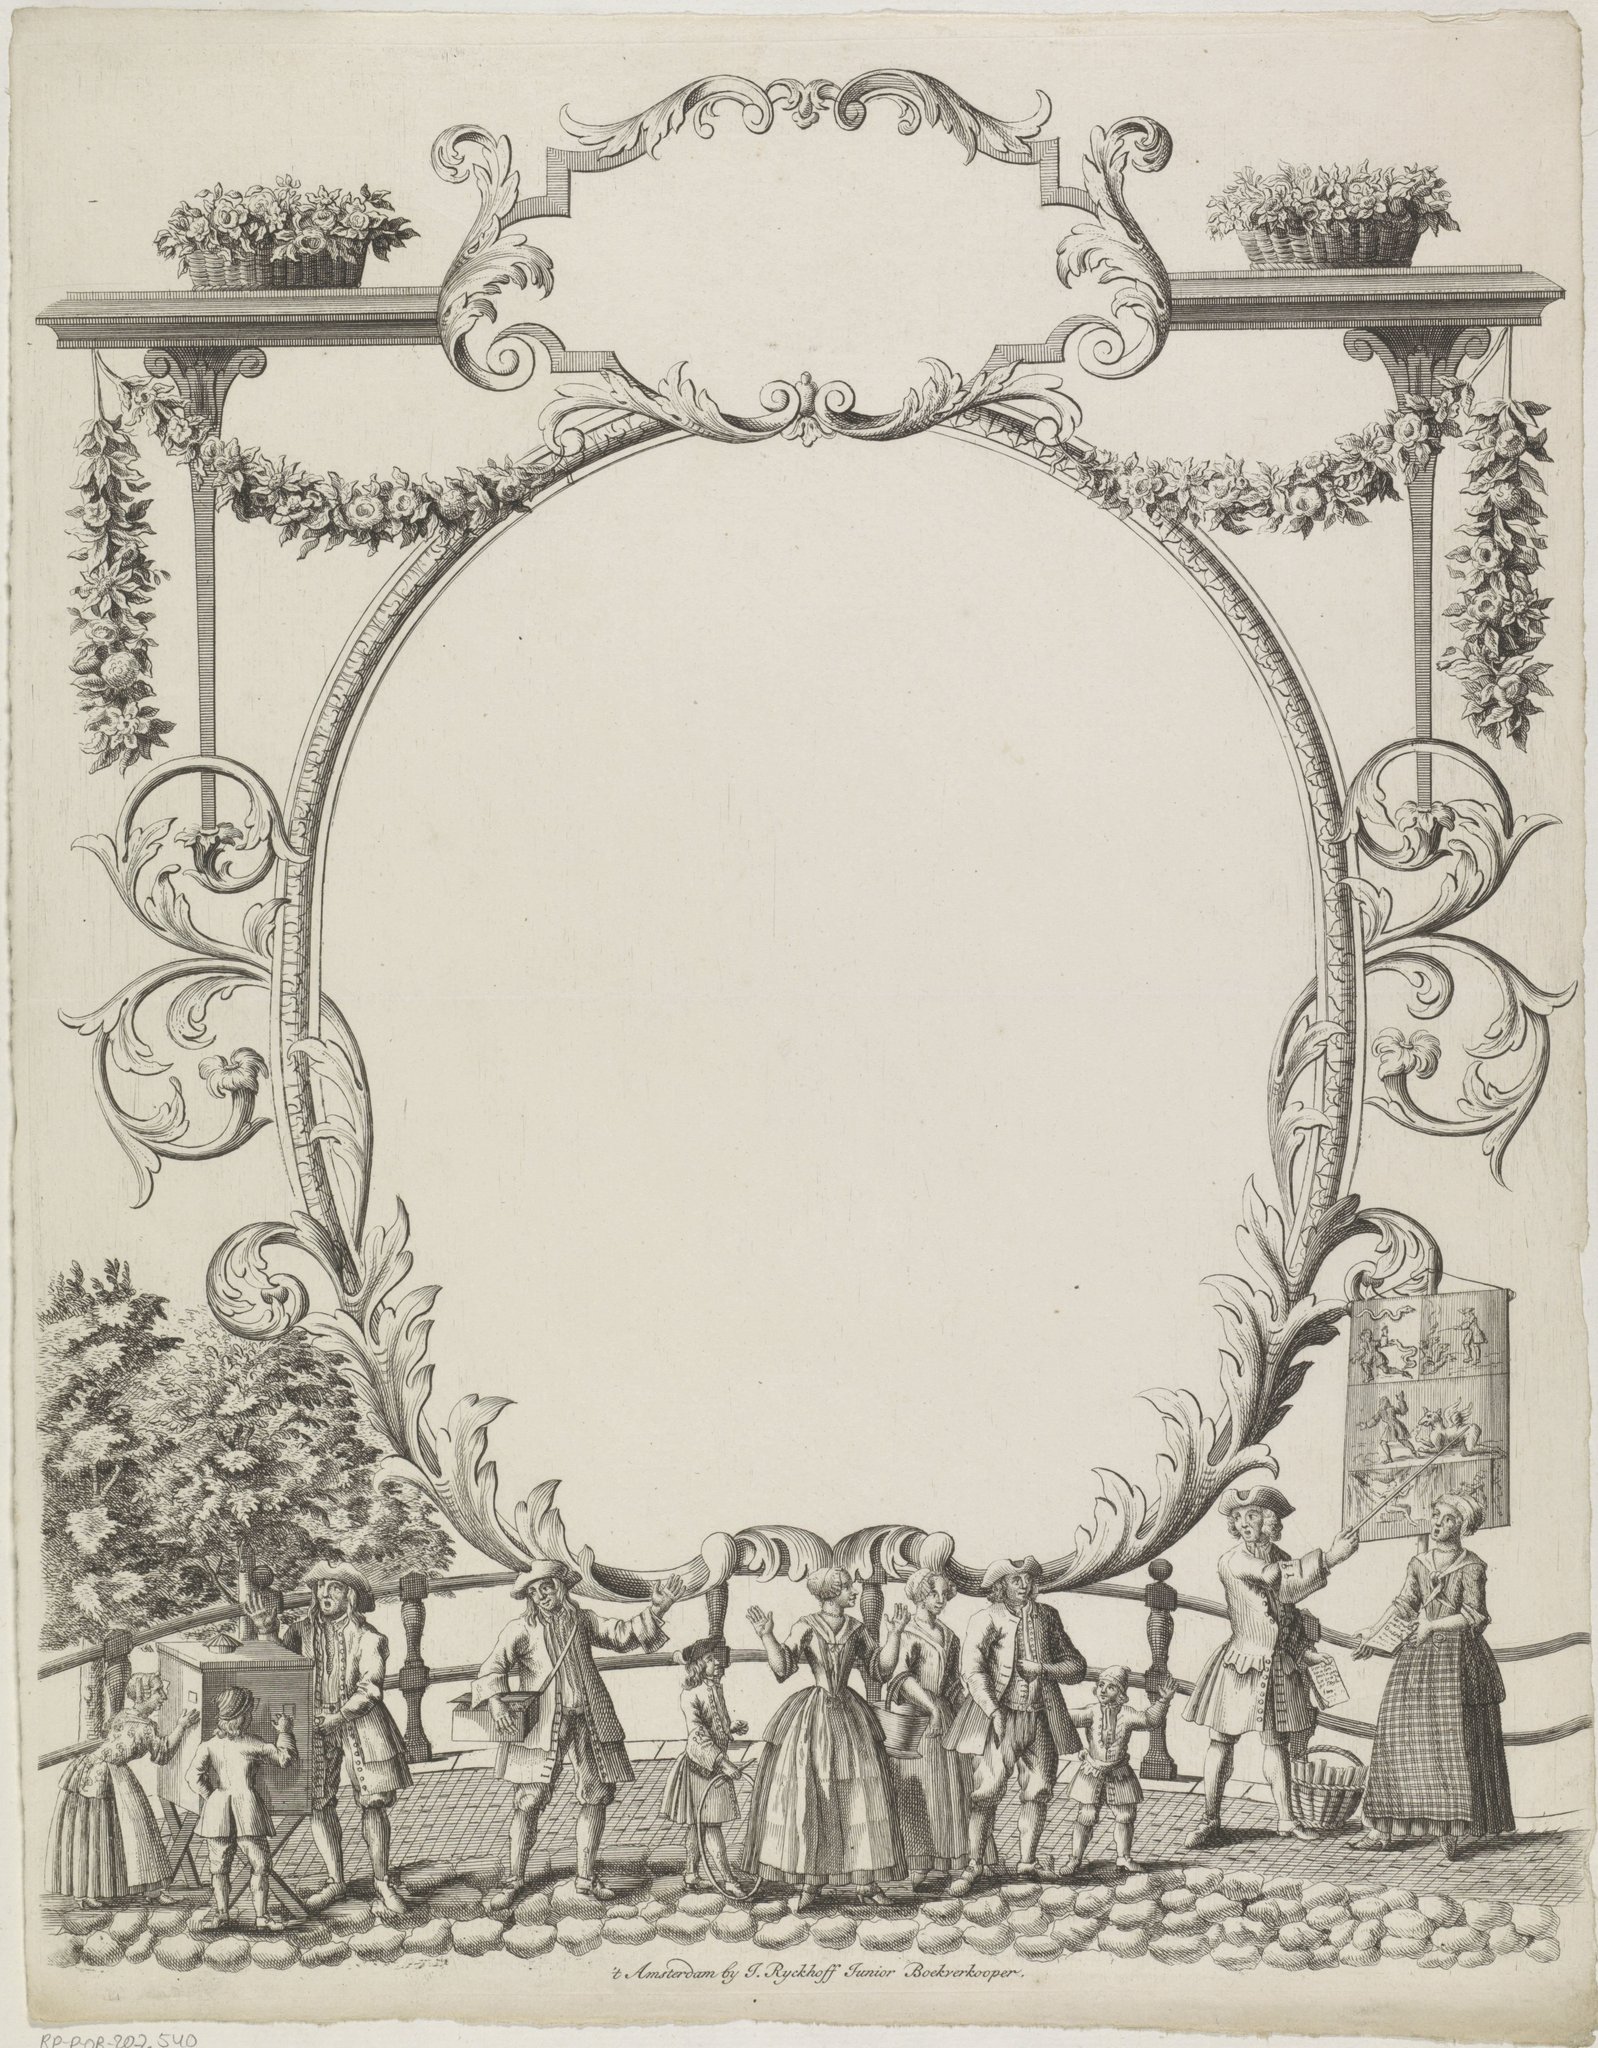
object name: wensbrief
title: Wensbrief met activiteiten op straat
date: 1738-1749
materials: paper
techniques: etching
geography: amsterdam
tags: vocal music, singing - cc - out of doors, peep-show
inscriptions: collector's mark: Lugt 2760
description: Wensbrief met onbeschreven cartouche binnen een decoratief kader met voorstellingen van activiteiten op straat, zoals mensen die straatliederen zingen en kinderen die in een kijkkast gluren.